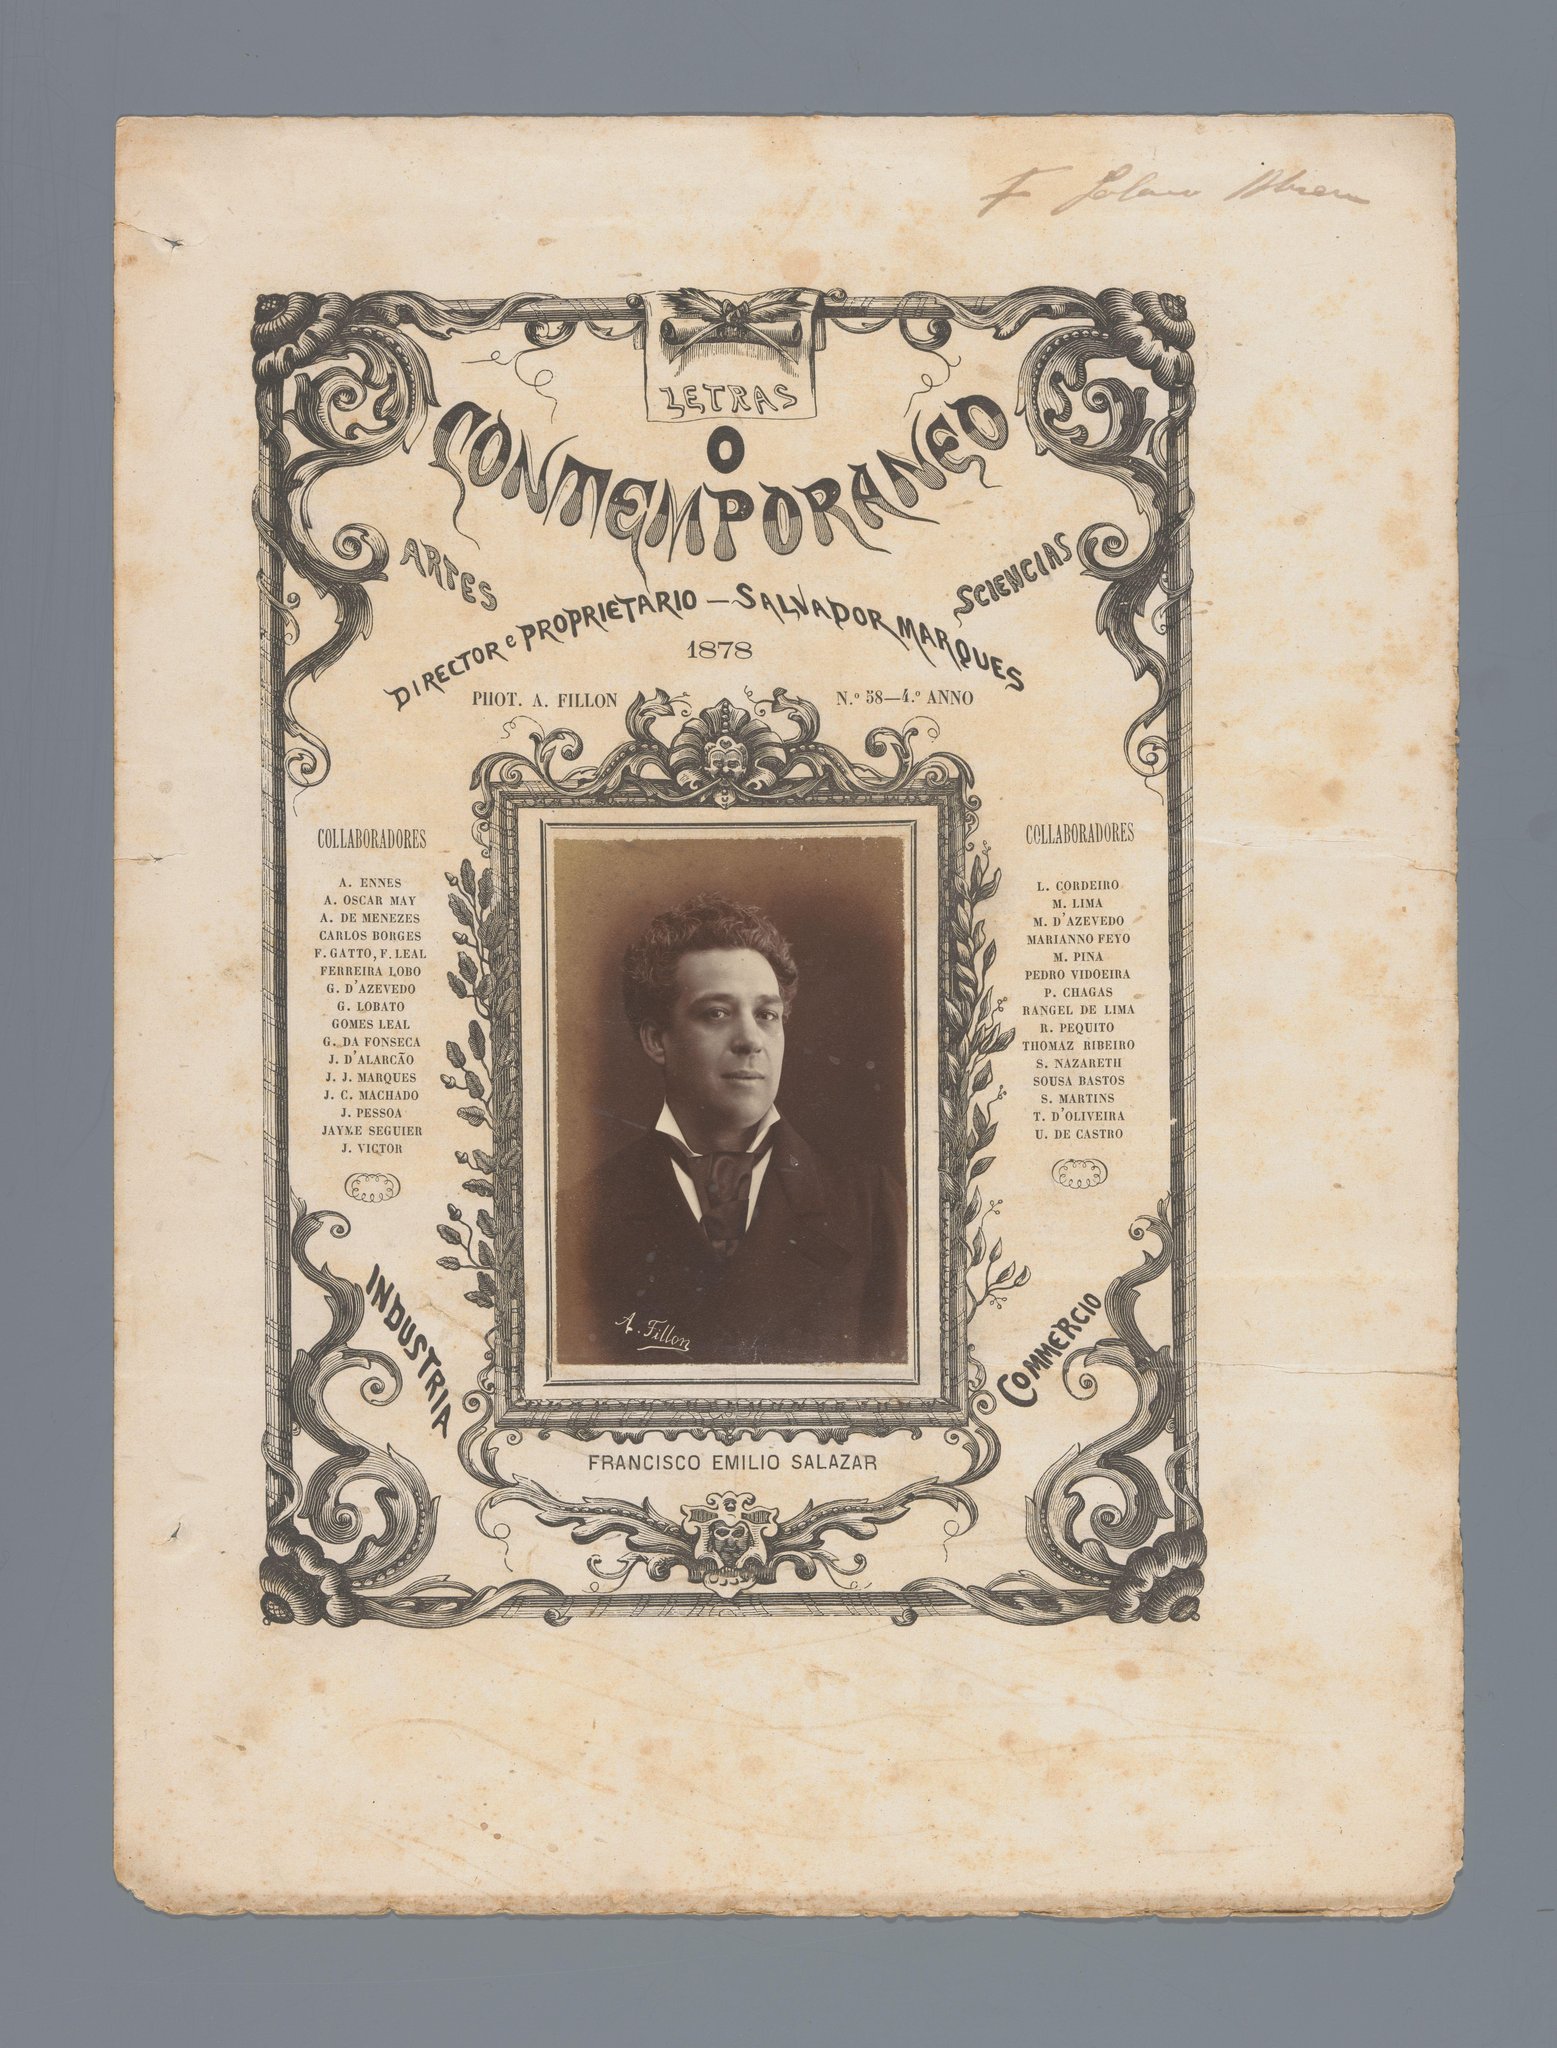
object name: photograph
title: O contemporaneo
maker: alfred fillon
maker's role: fotograaf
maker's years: 1825-1881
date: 1873-1878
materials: paper, photographic support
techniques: albumen print, printing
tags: historical persons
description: Op de voorpagina bevindt zich een portret van Francisco Emilio Salazar.